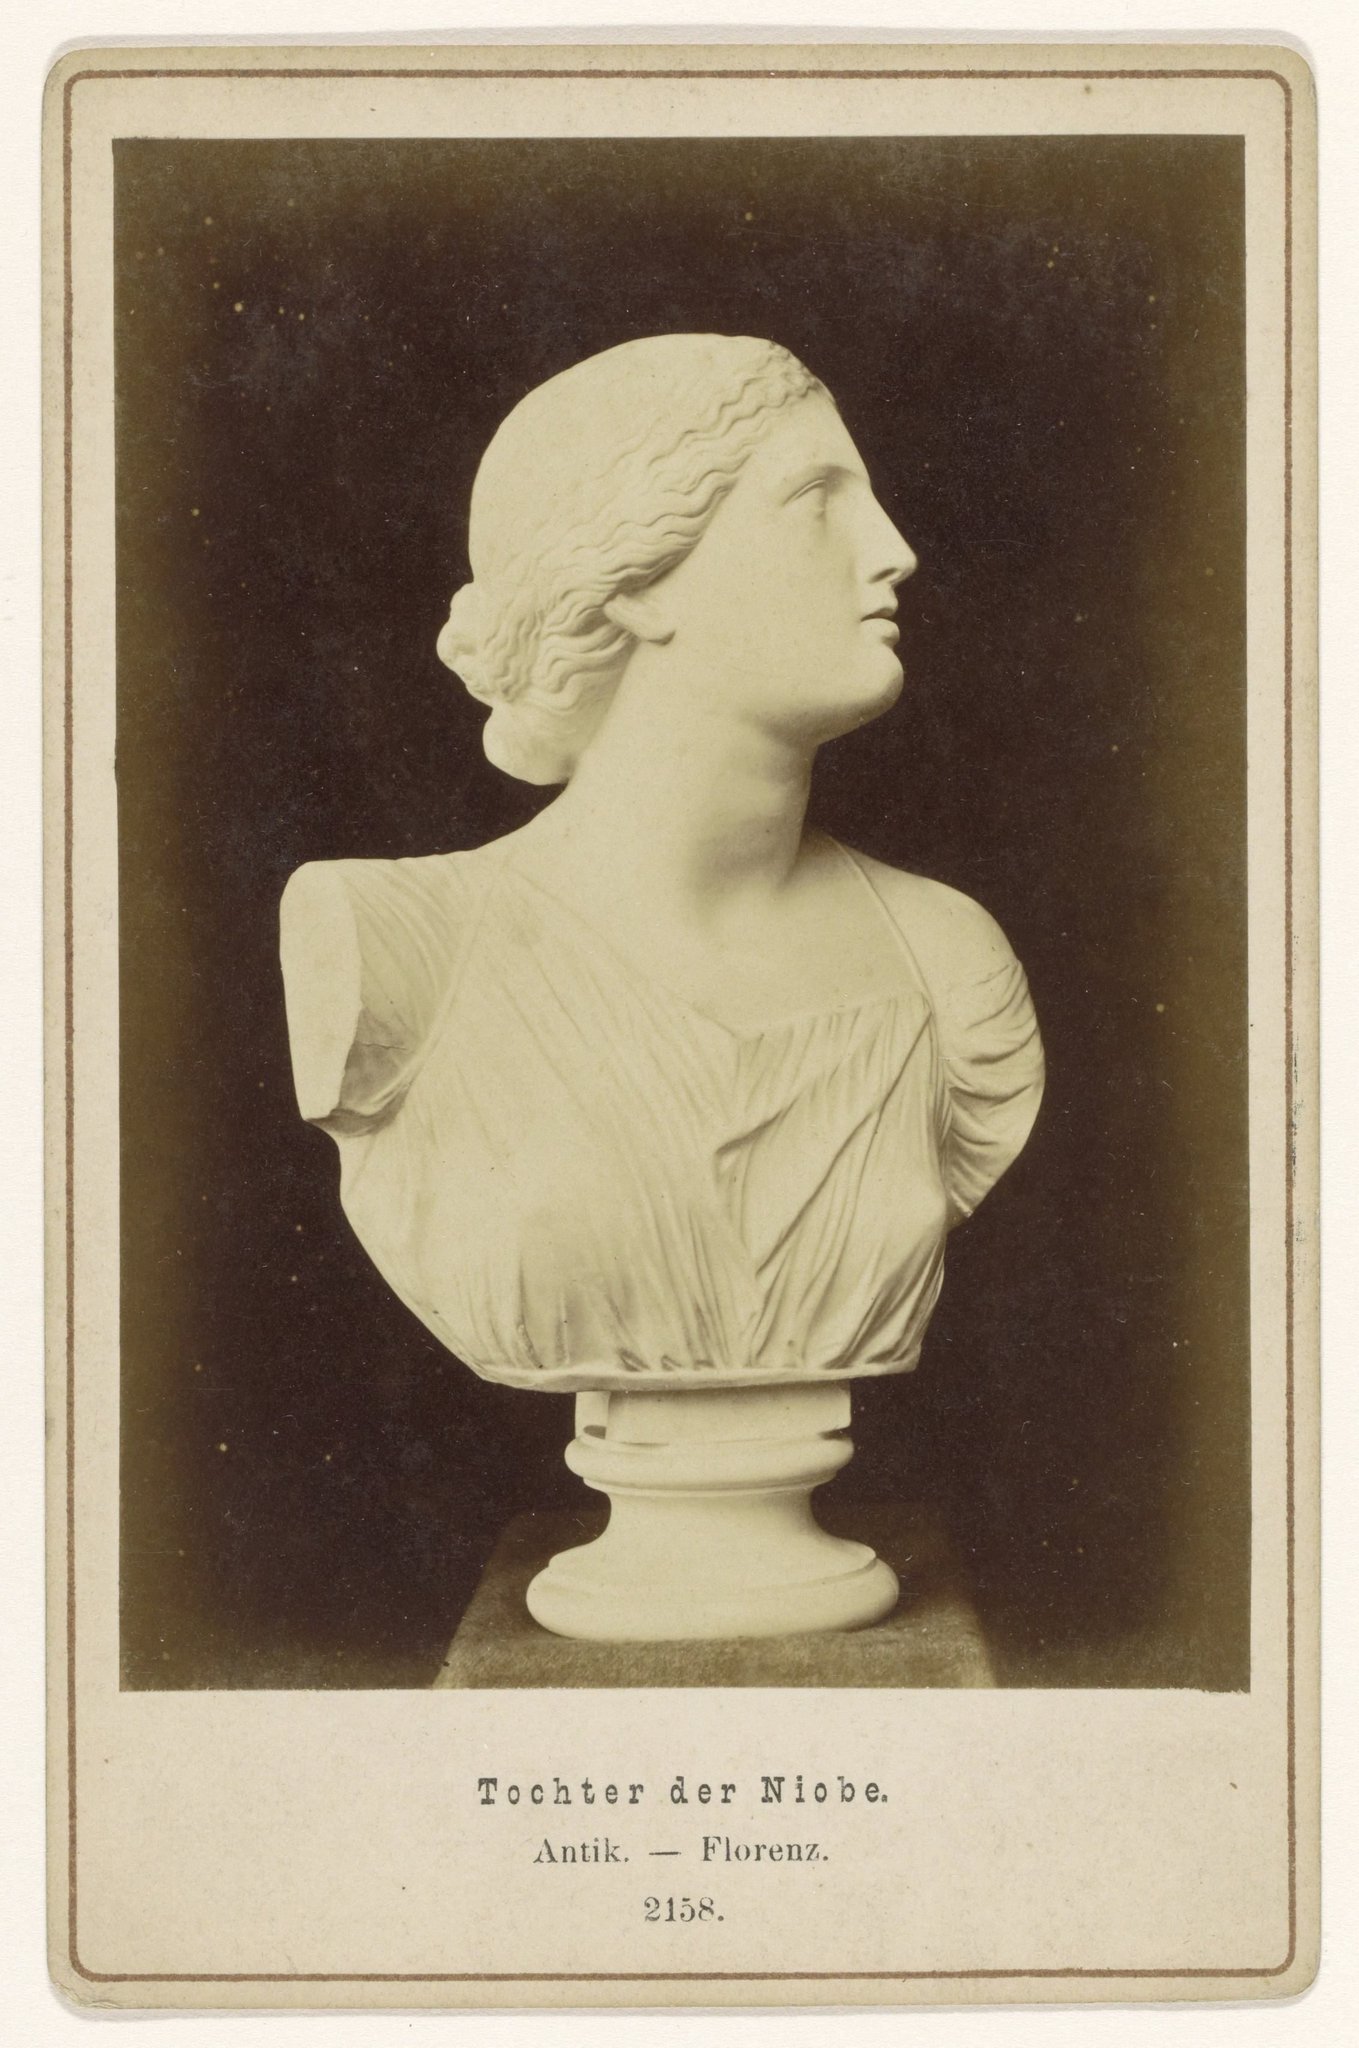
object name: cabinet photograph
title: Tochter der Niobe. Antik. - Florenz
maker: s.p. christmann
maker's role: publisher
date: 1870-1890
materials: cardboard, paper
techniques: albumen print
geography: berlin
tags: piece of sculpture, reproduction of a piece of sculpture, (story of) niobe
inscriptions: title: ‘Tochter der Niobe./ Antik. - Florenz./ 2158.’, collector's mark: ‘Vosmaer’